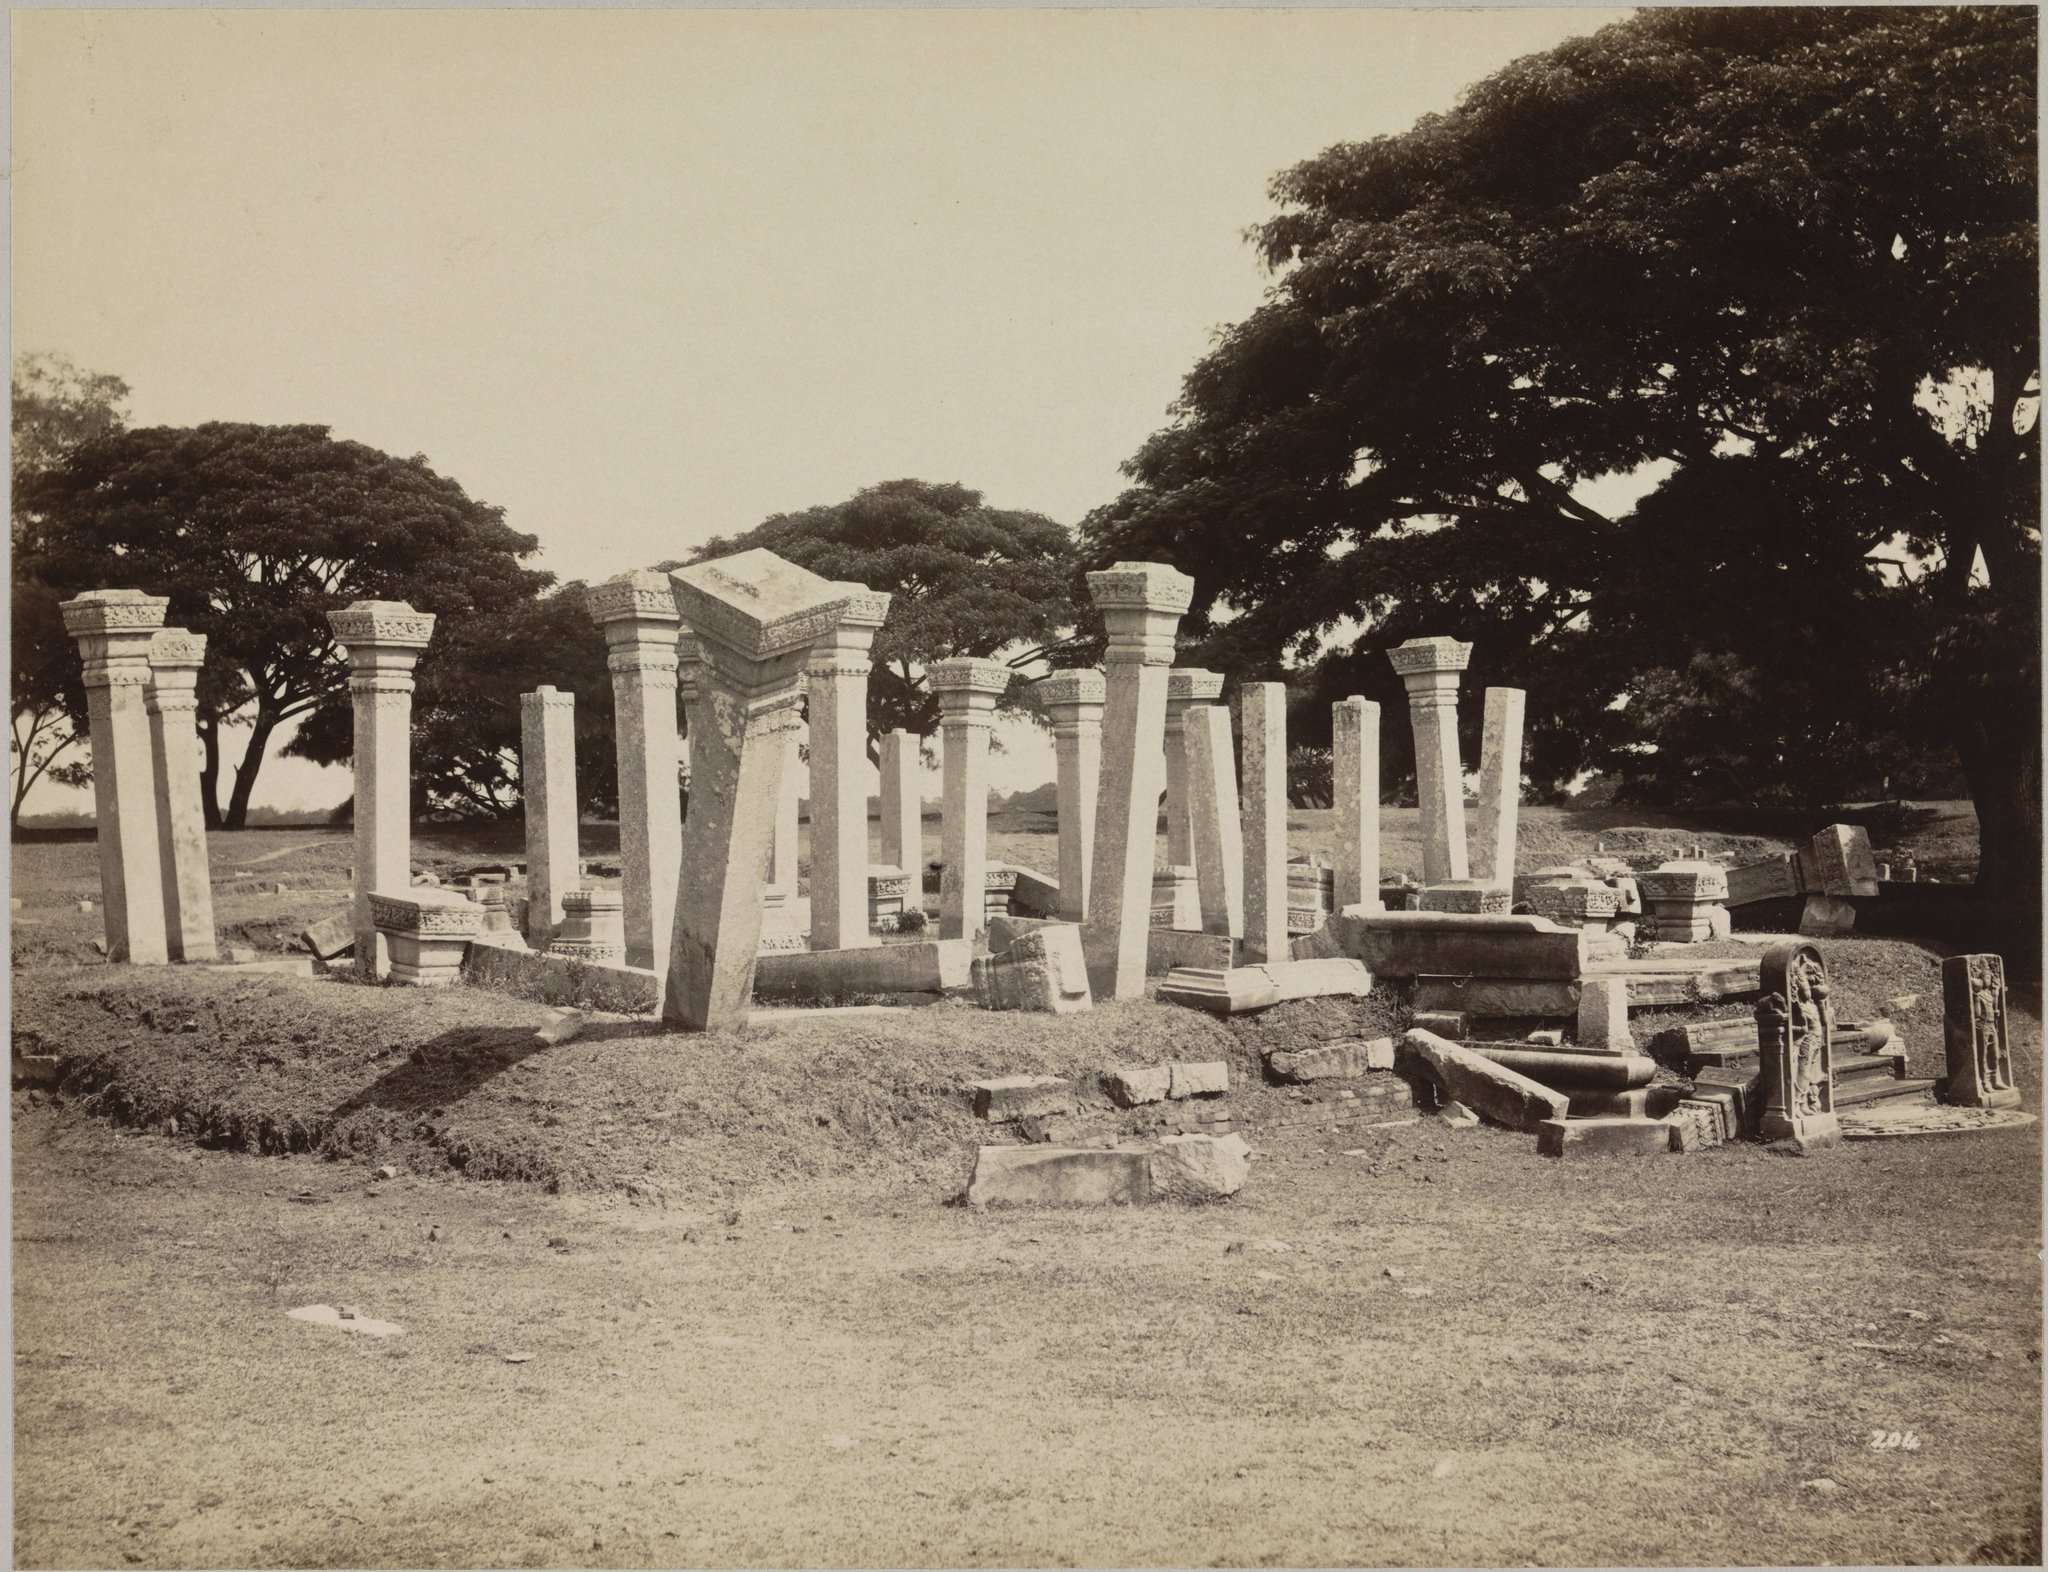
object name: photograph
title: Ruins, Anuradhapura, Sri Lanka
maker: Anonymous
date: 1895-1915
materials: cardboard, paper, photographic support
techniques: albumen print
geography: anuradhapura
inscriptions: inscription: ‘10. Anuradhapura.’, number: ‘204’